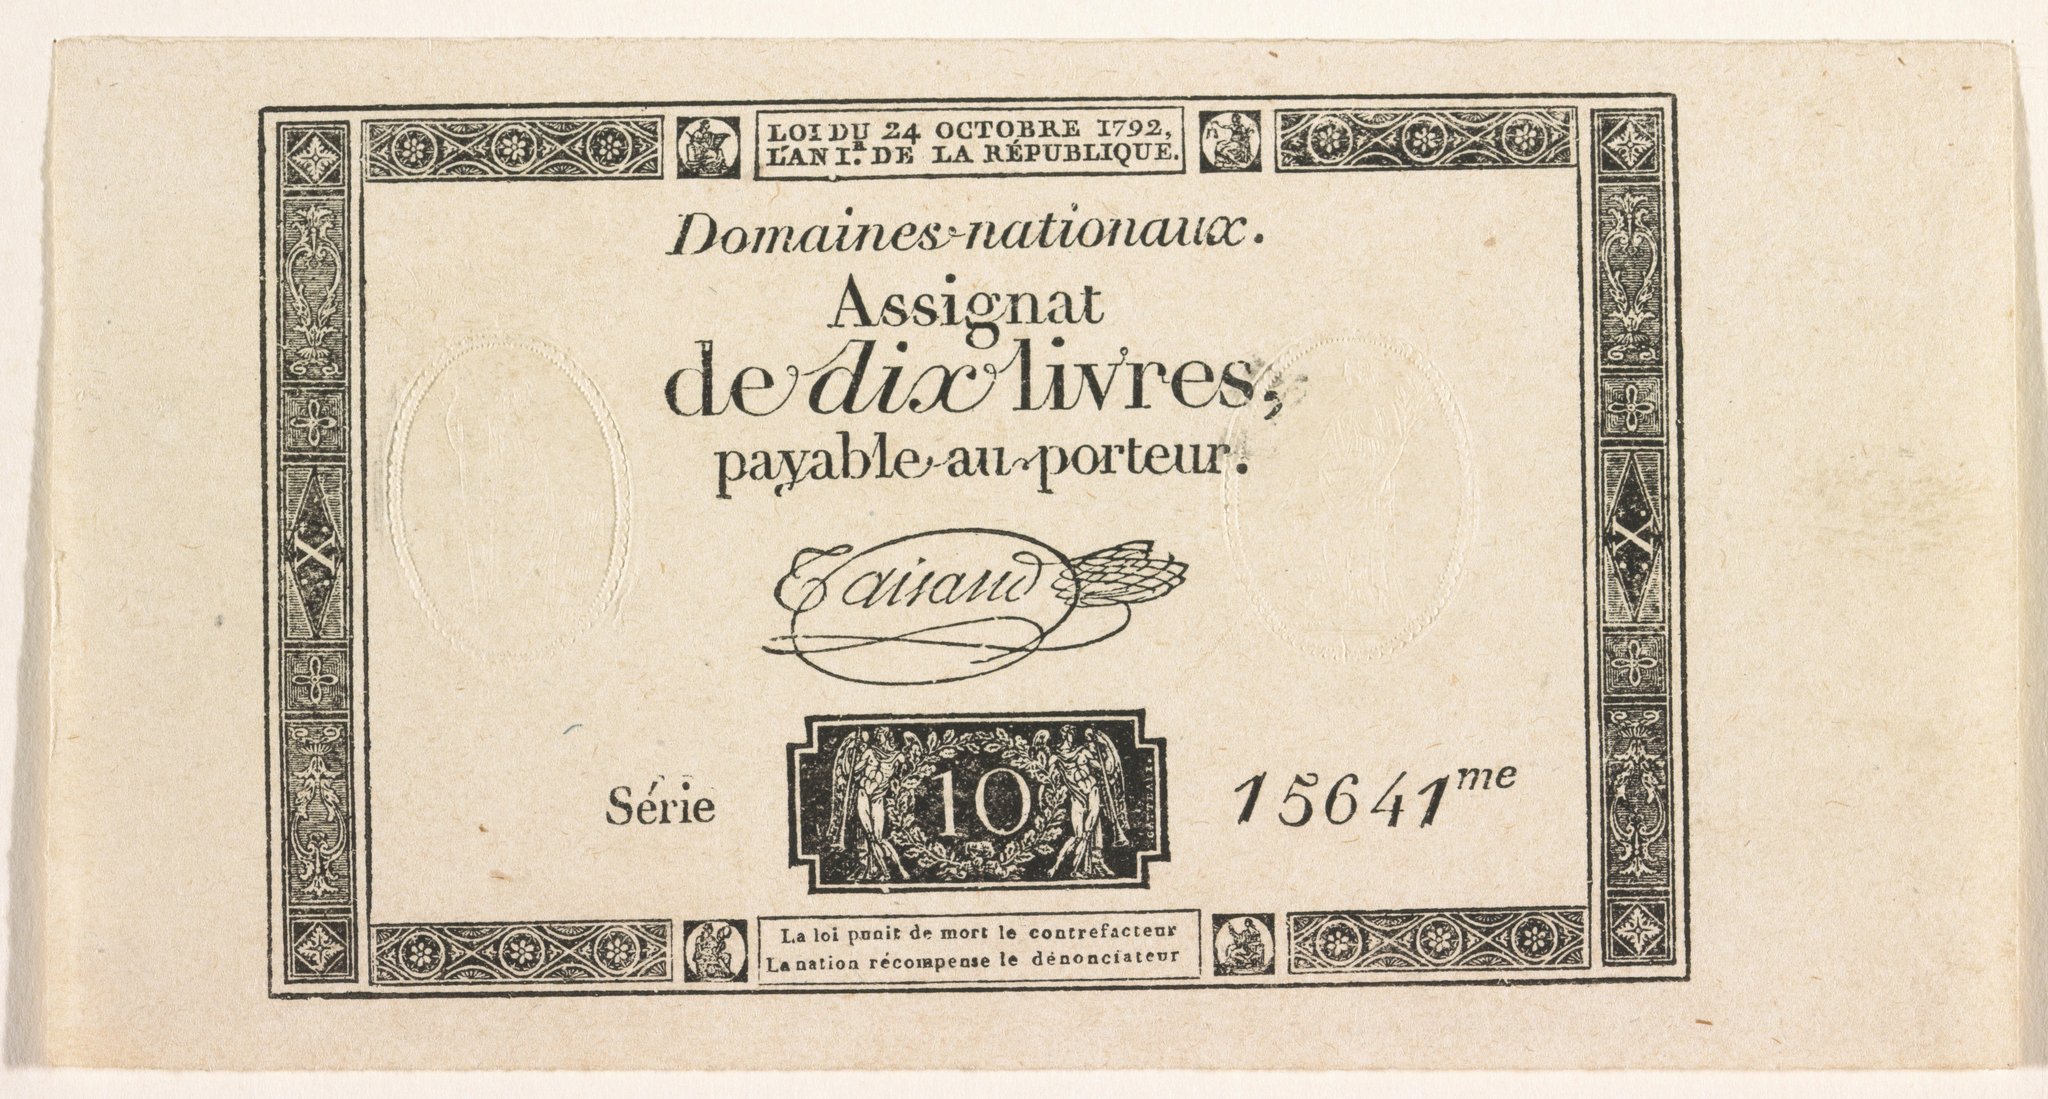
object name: print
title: Assignaat van 10 livres, 1792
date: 1792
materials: paper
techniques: blind stamped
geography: france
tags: bank-note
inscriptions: collector's mark: Lugt 2228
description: Assignaat van 10 livres. In omloop gebracht door de Domaines nationaux, serie 15641, volgens de wet van 24 oktober 1792.